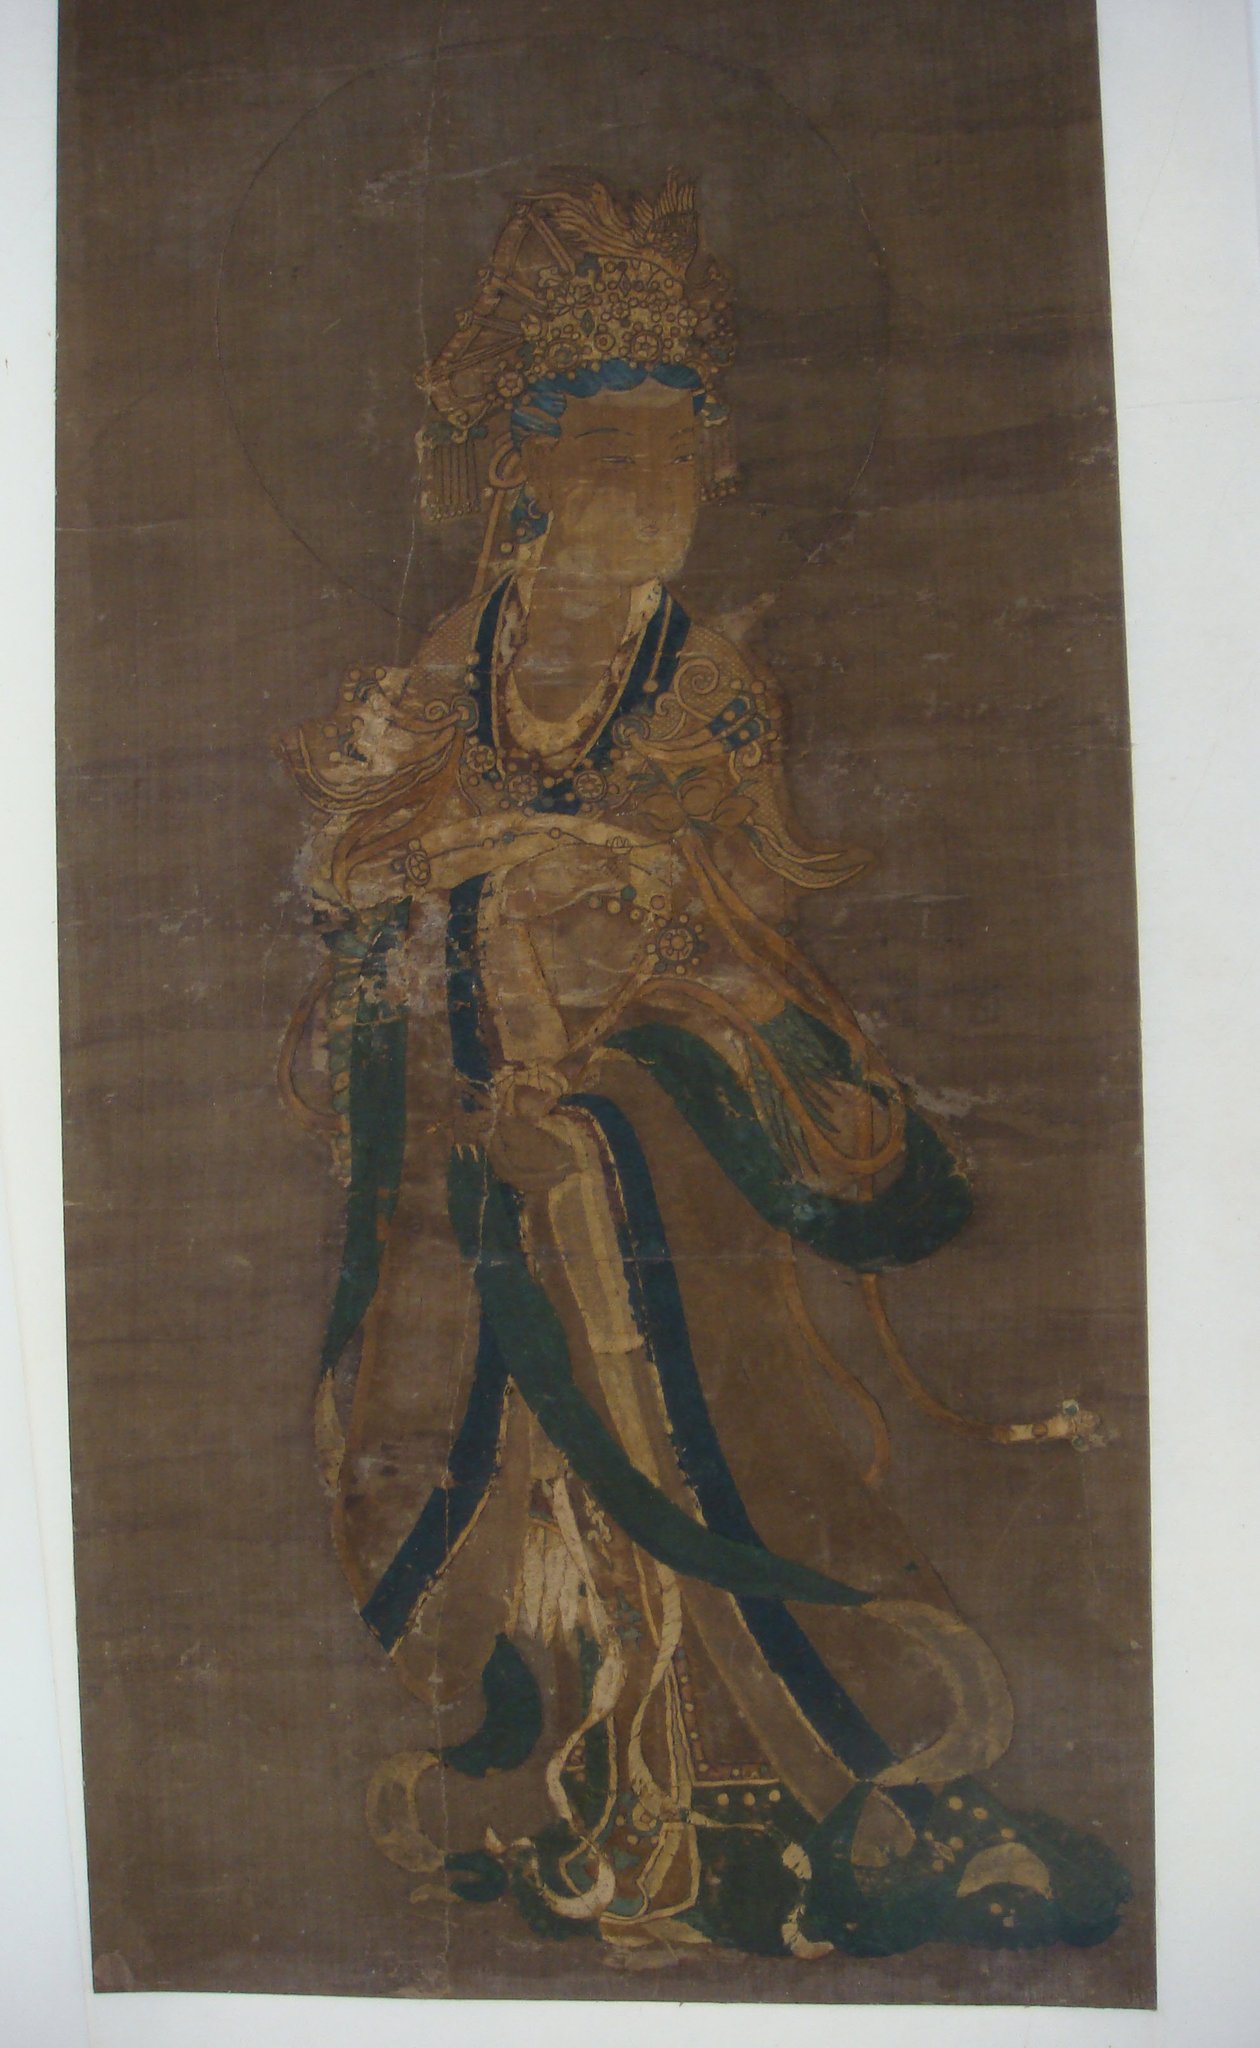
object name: hanging scroll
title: Figure of a Noble Lady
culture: chinese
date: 1368-1644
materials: ink, paper, pigment, silk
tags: women